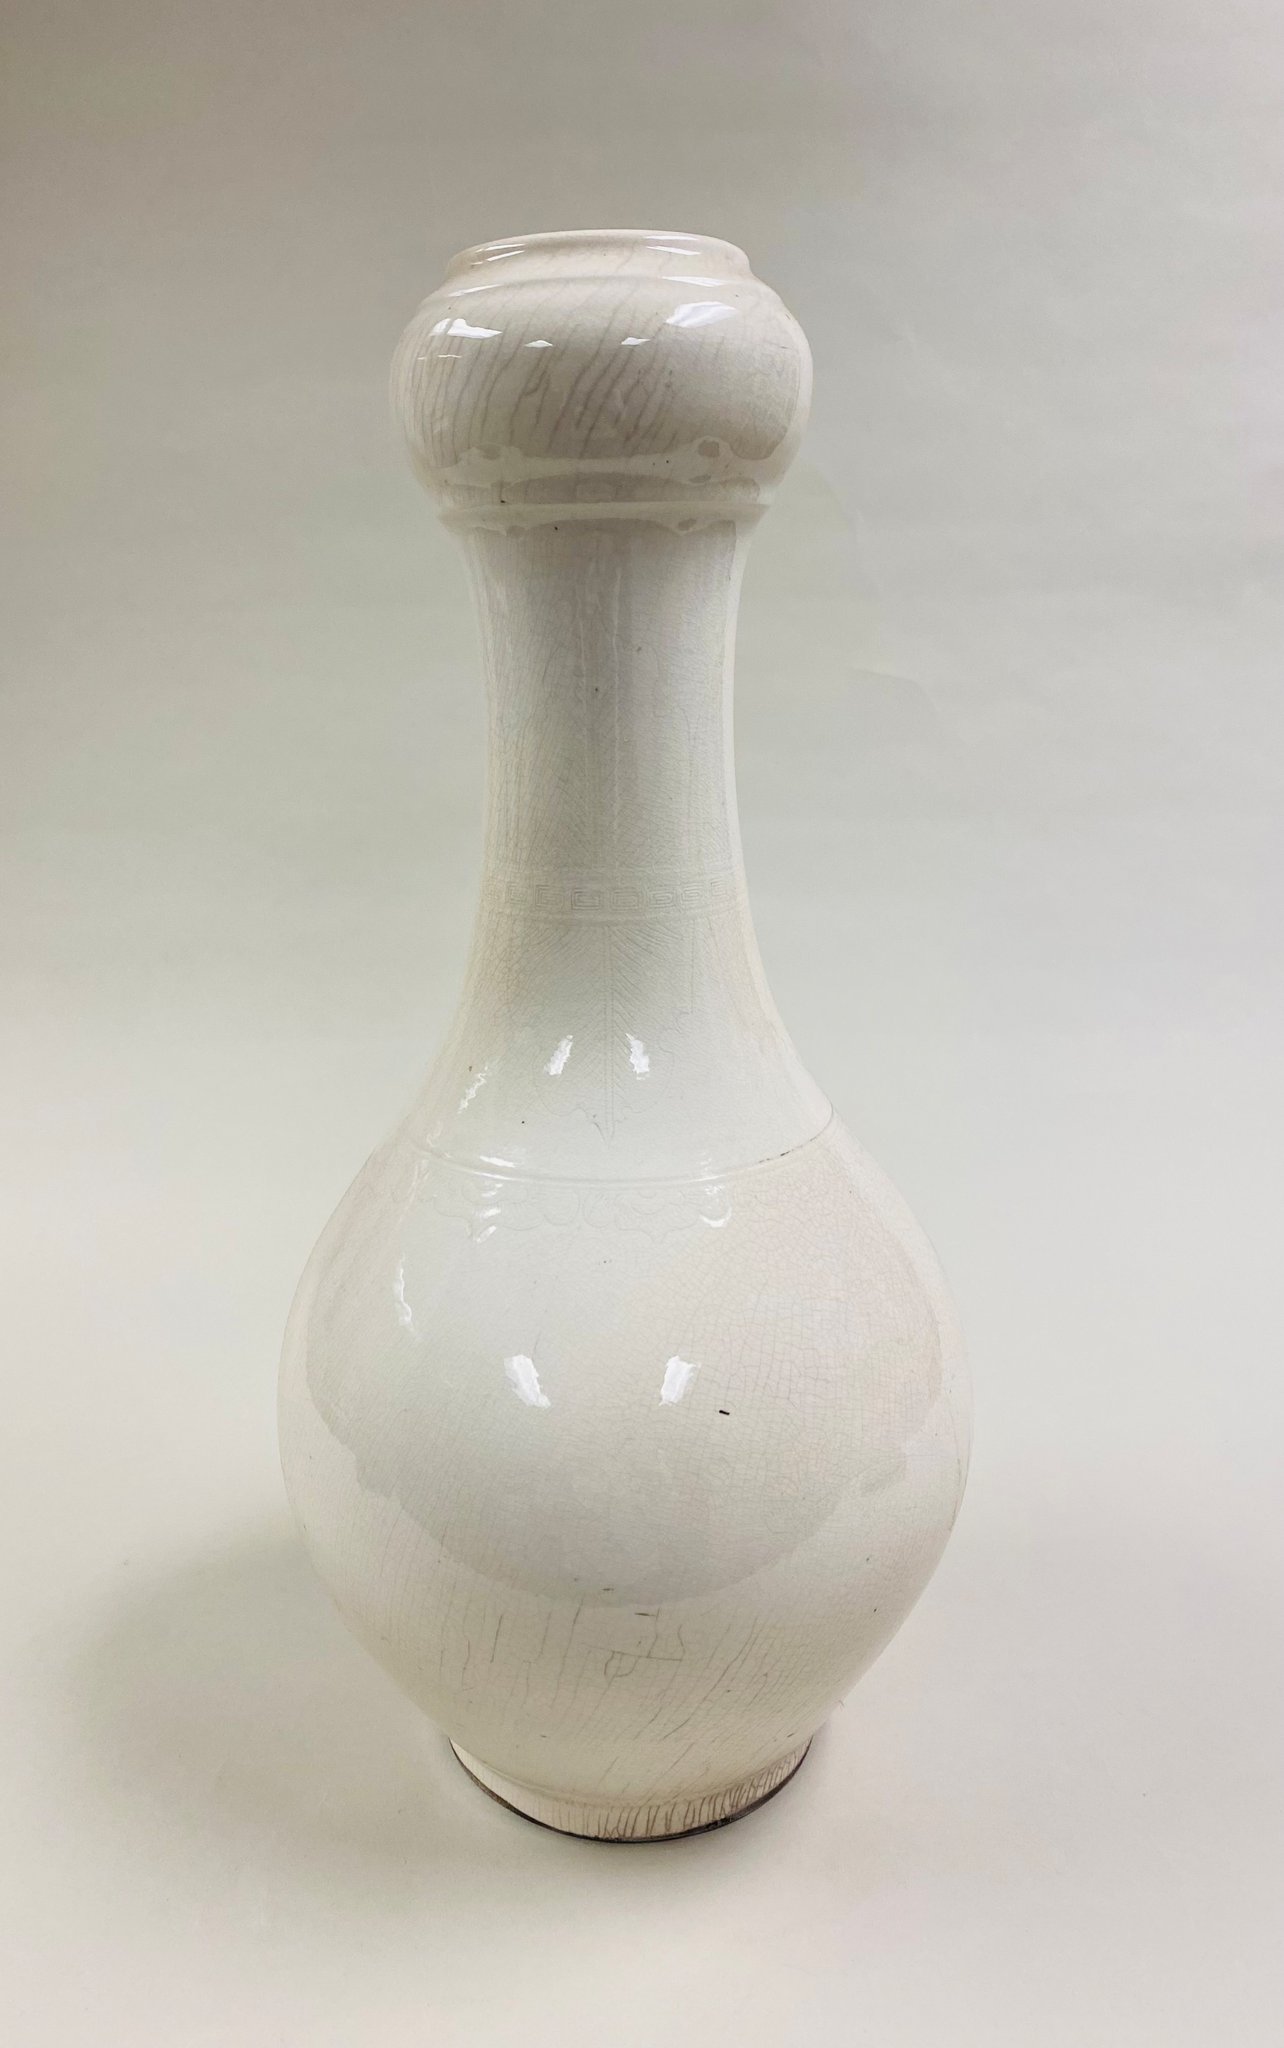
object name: vase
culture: chinese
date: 1701-1800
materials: glaze, porcelain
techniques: incising